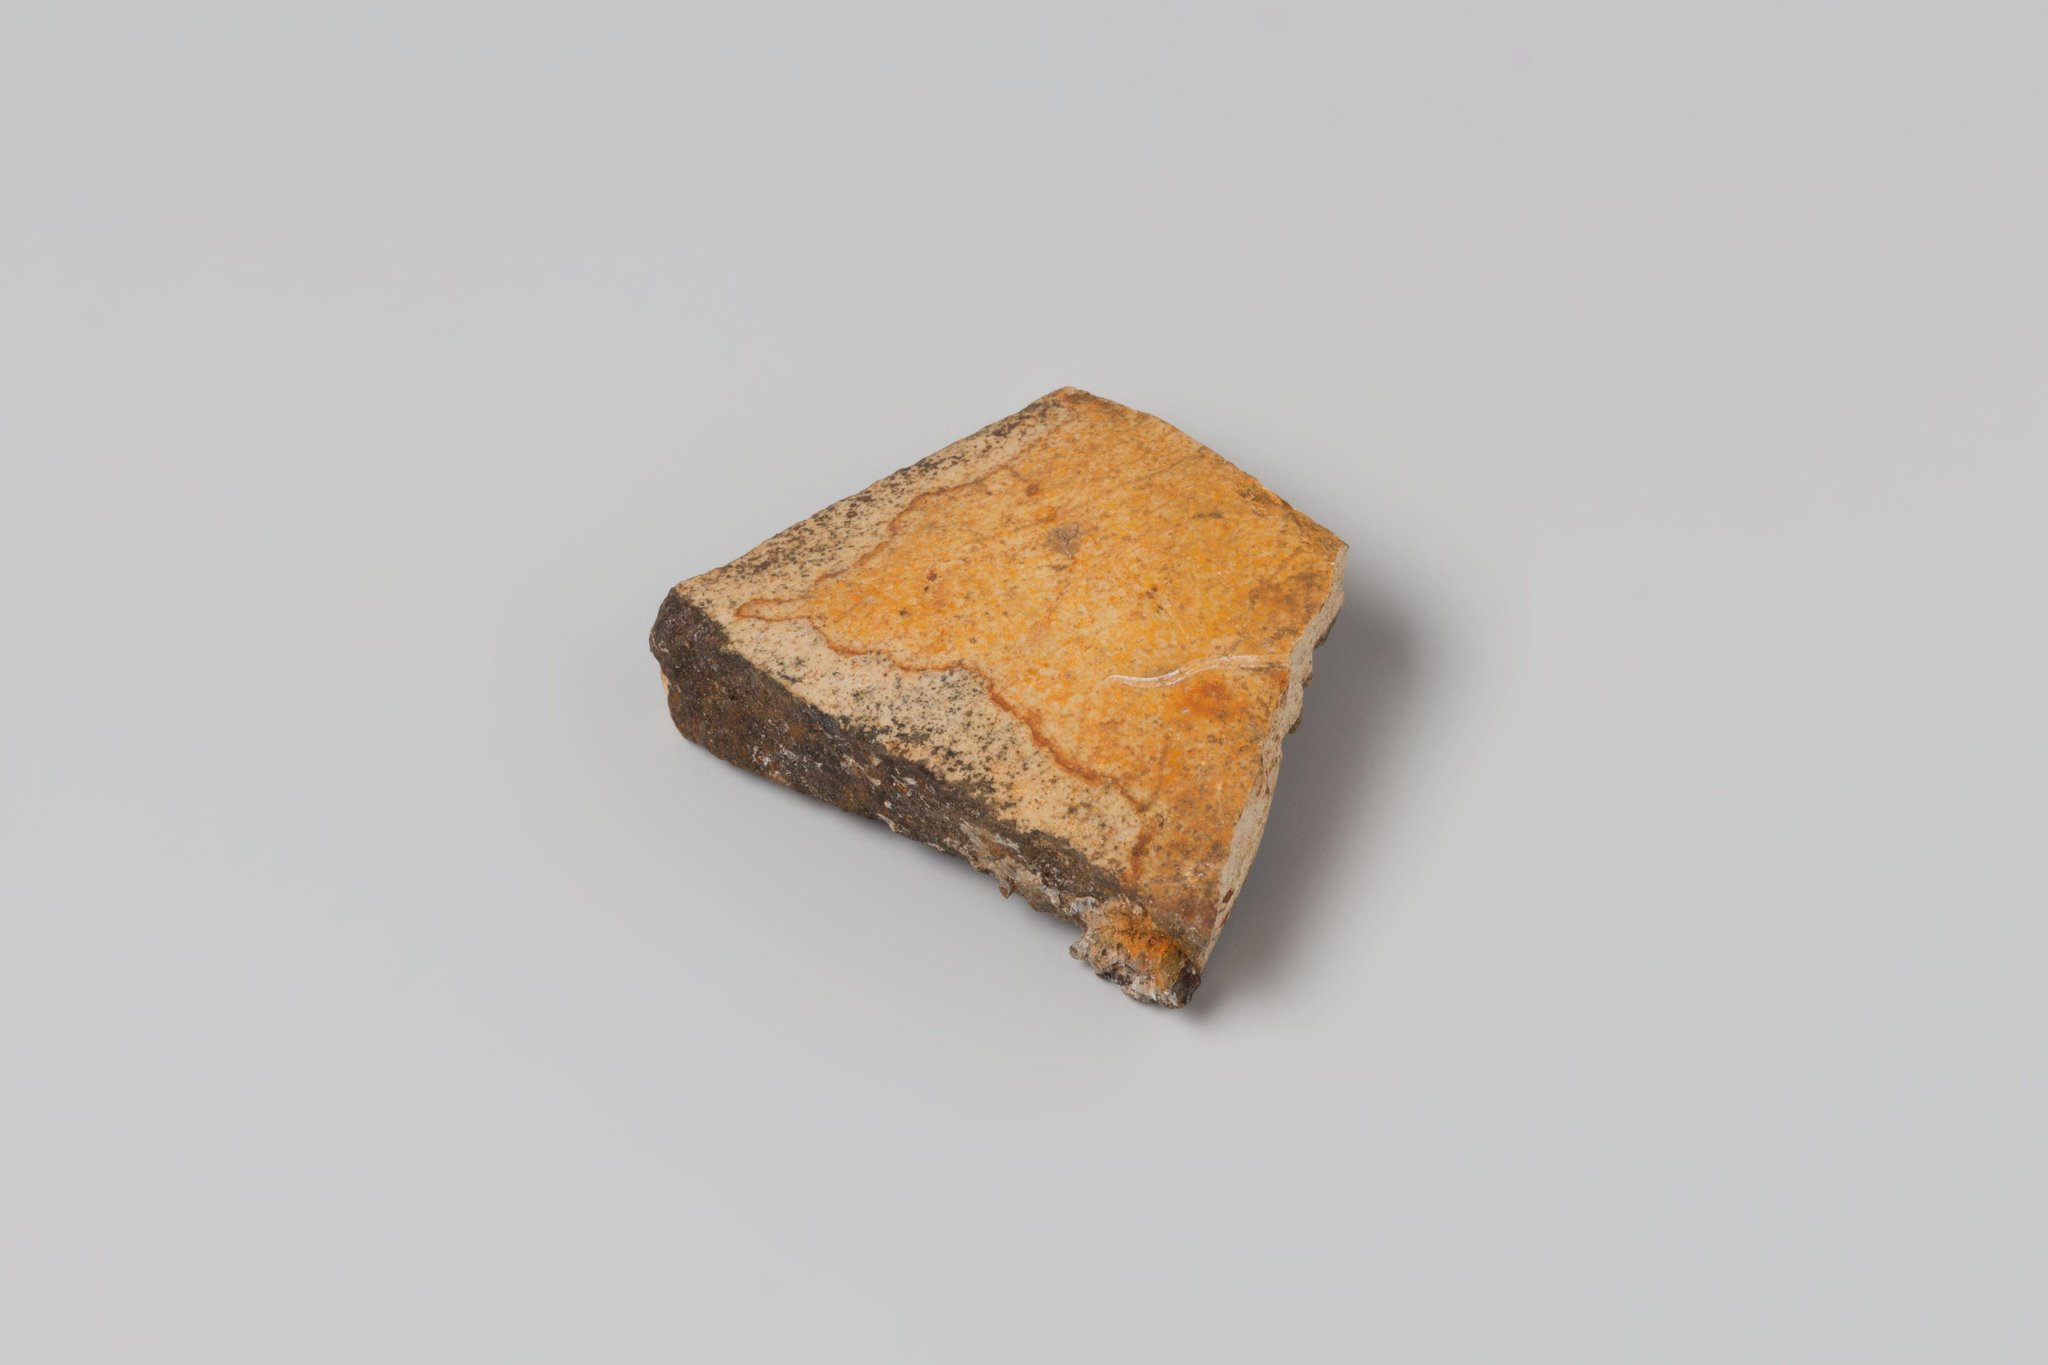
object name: ewer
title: Scherf van een kan uit het wrak van de Oost-Indiëvaarder Hollandia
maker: Anonymous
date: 1700-1743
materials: stoneware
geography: cologne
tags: verenigde oostindische compagnie, hollandia (schip), annet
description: Stoneware, Rhenish, Frechen-ware, jug; fragm of body.